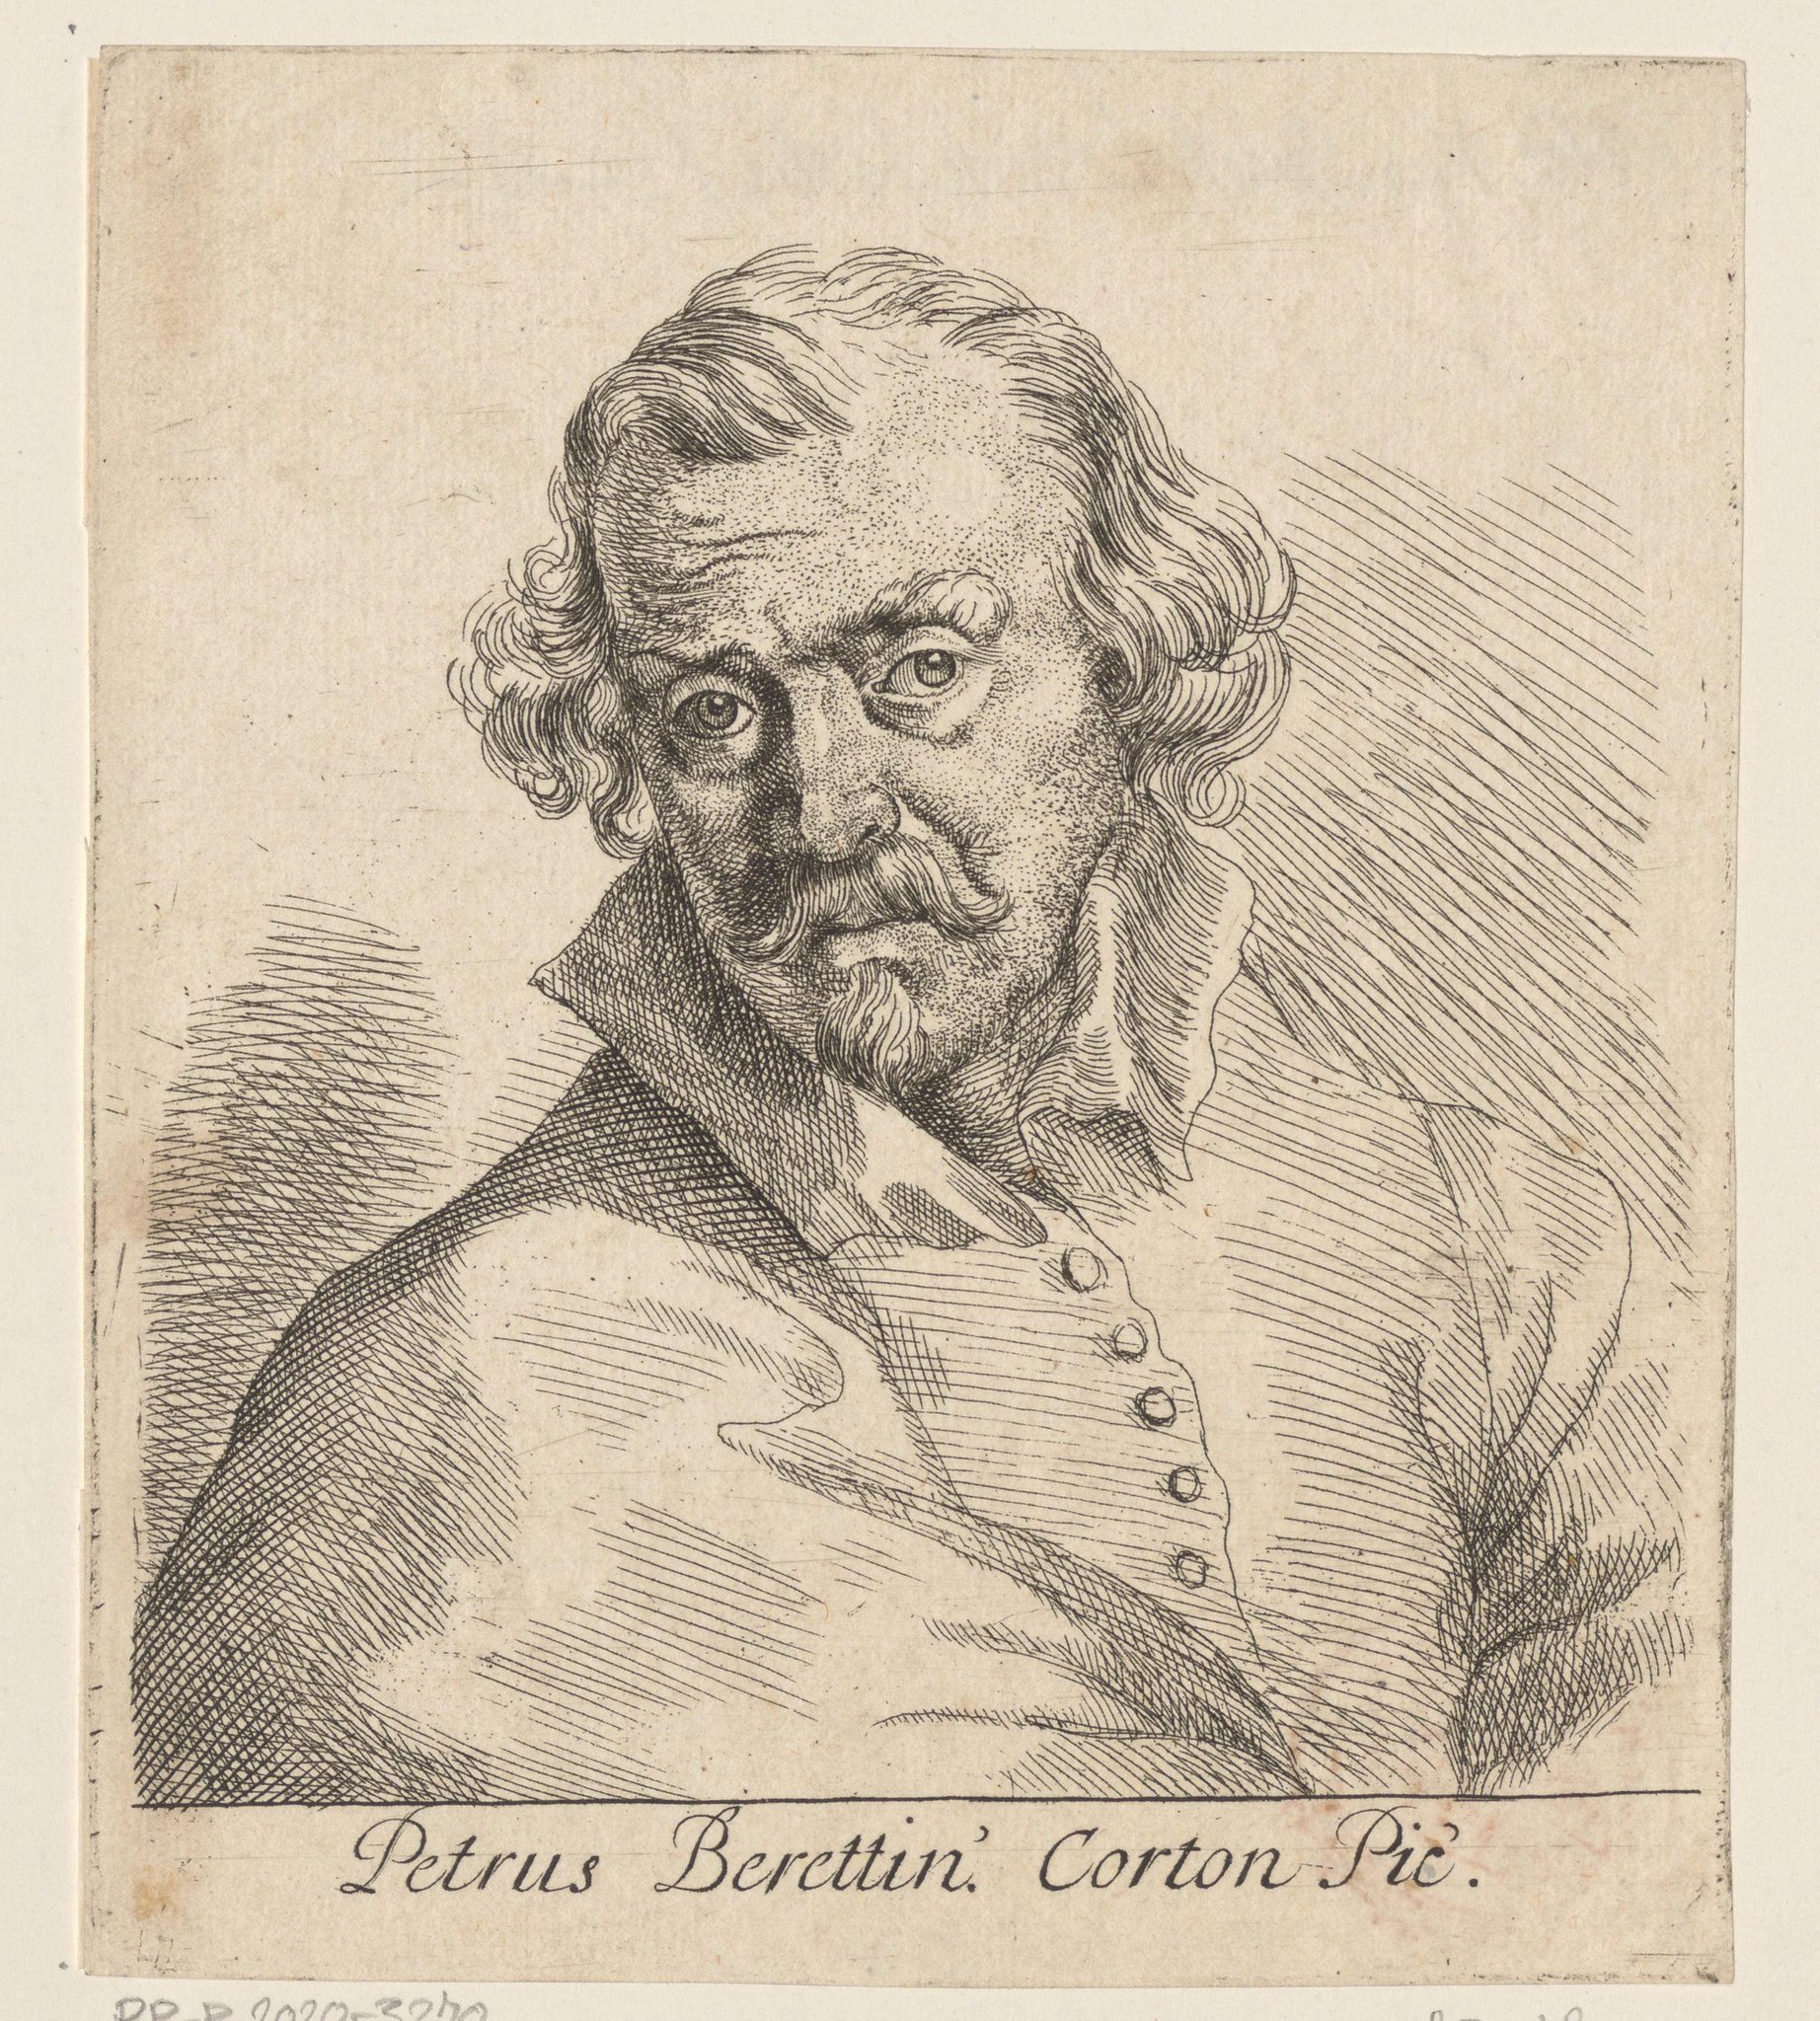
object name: print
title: Portret van Pietro da Cortona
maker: Anonymous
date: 1750-1799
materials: paper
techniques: etching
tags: rome, painter, draughtsman, designer, pietro da cortona, historical persons, portrait, self-portrait of painter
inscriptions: collector's mark: Lugt 240